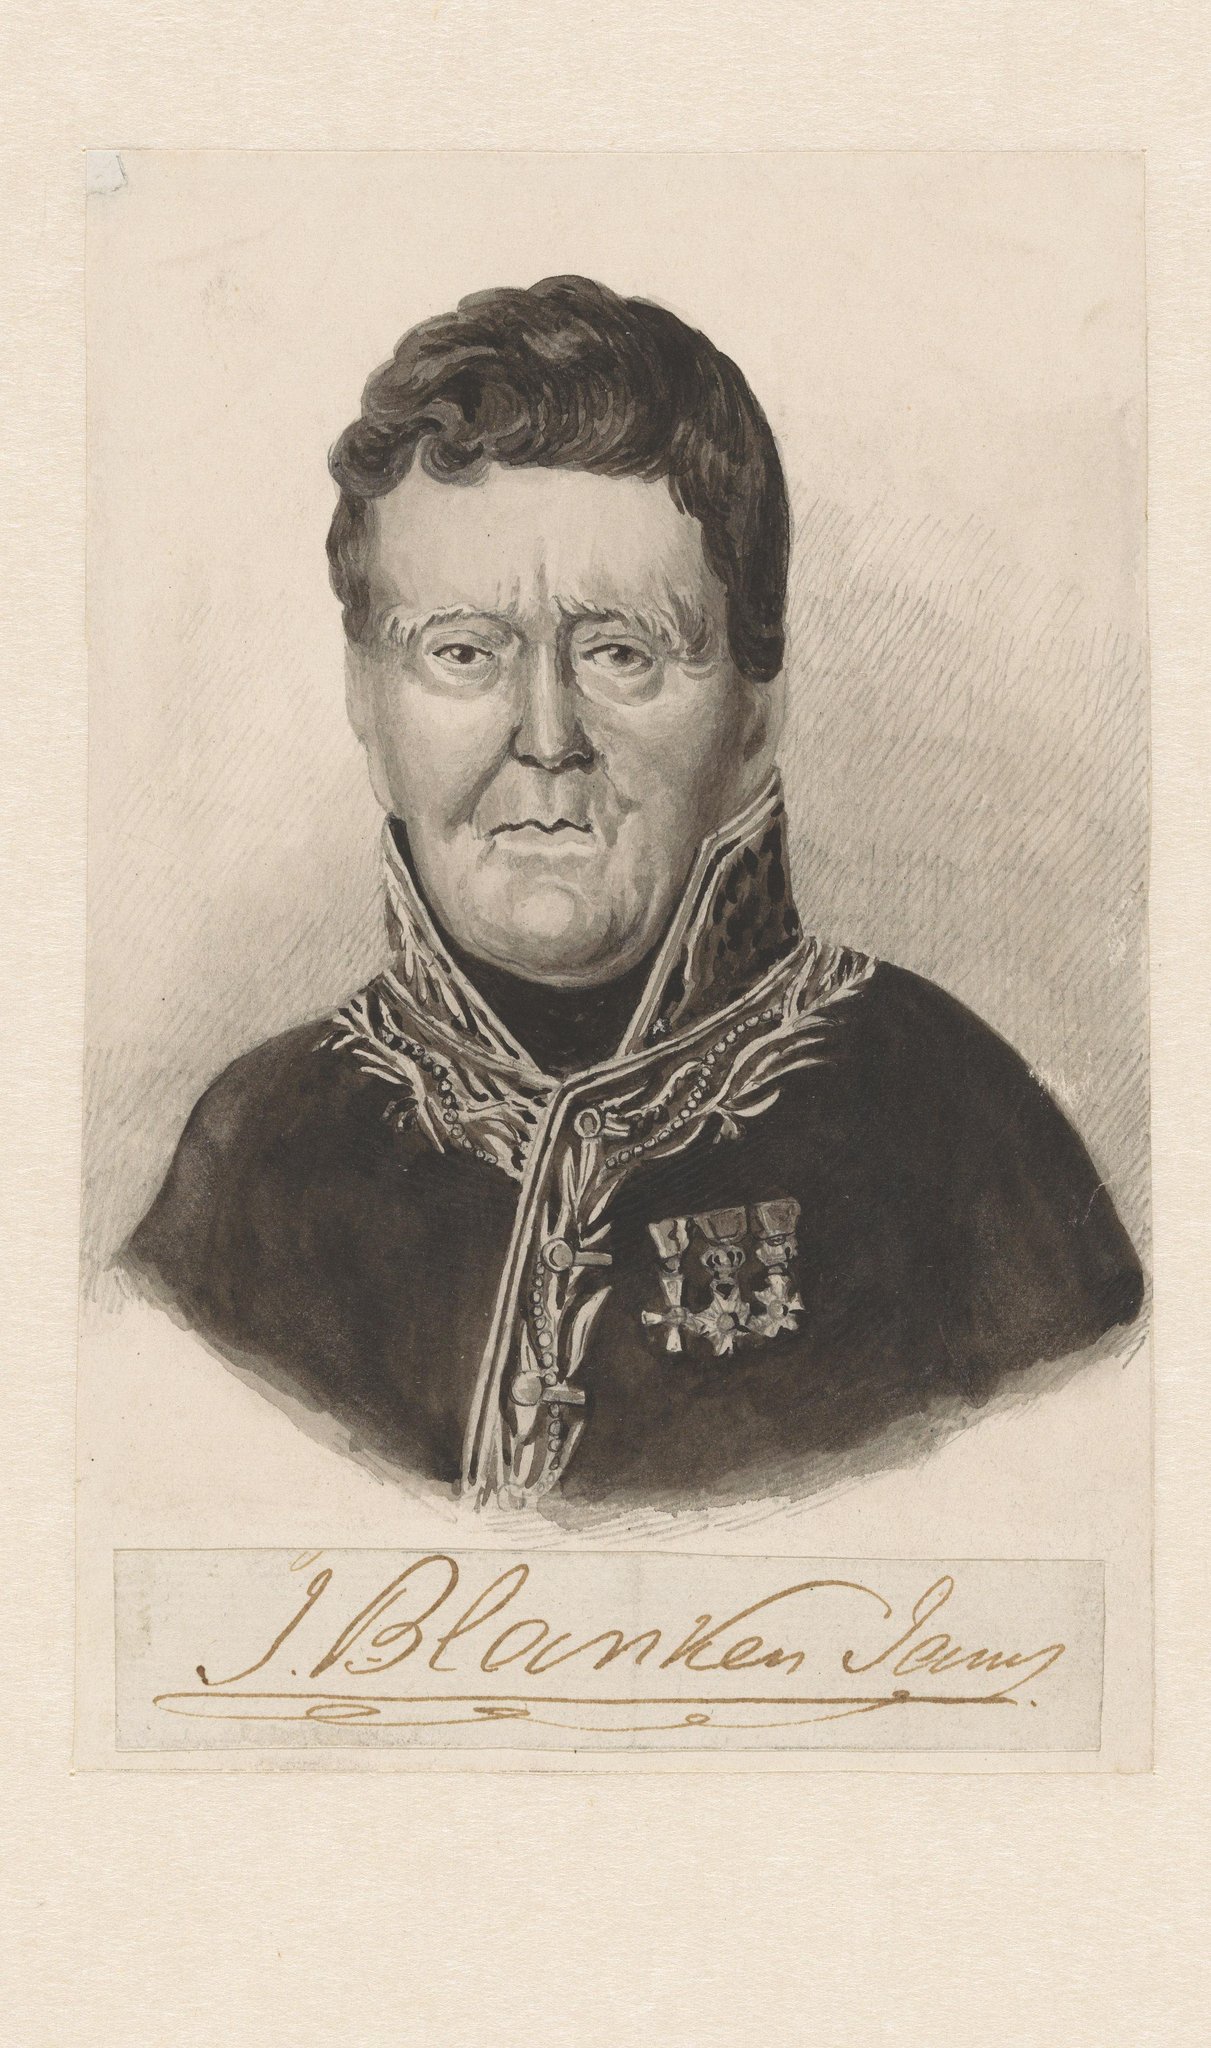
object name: drawing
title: Portret van Jan Blanken Jansz.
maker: Anonymous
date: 1800-1900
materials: paper, pencil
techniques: brush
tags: jan blanken jansz., historical persons